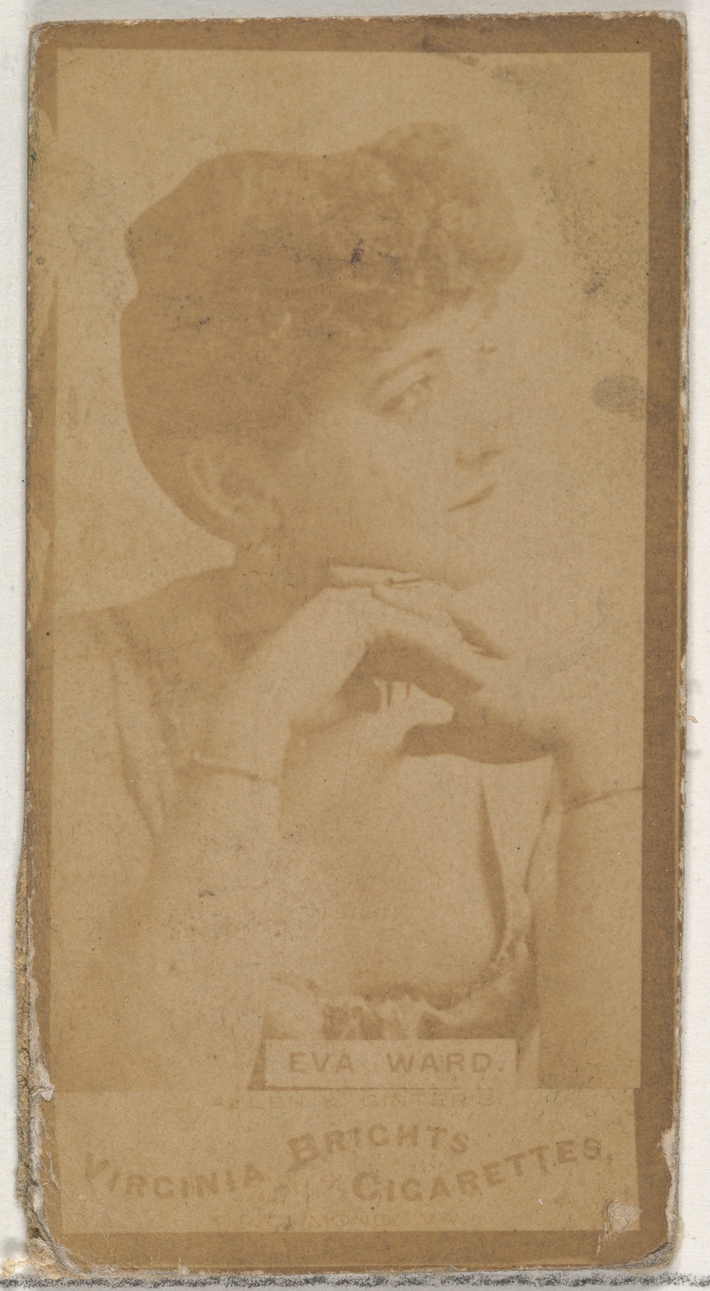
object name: photograph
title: Eva Ward, from the Actors and Actresses series (N45, Type 3) for Virginia Brights Cigarettes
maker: allen & ginter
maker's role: publisher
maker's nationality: american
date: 1888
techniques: albumen silver print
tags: portraits,women,actresses